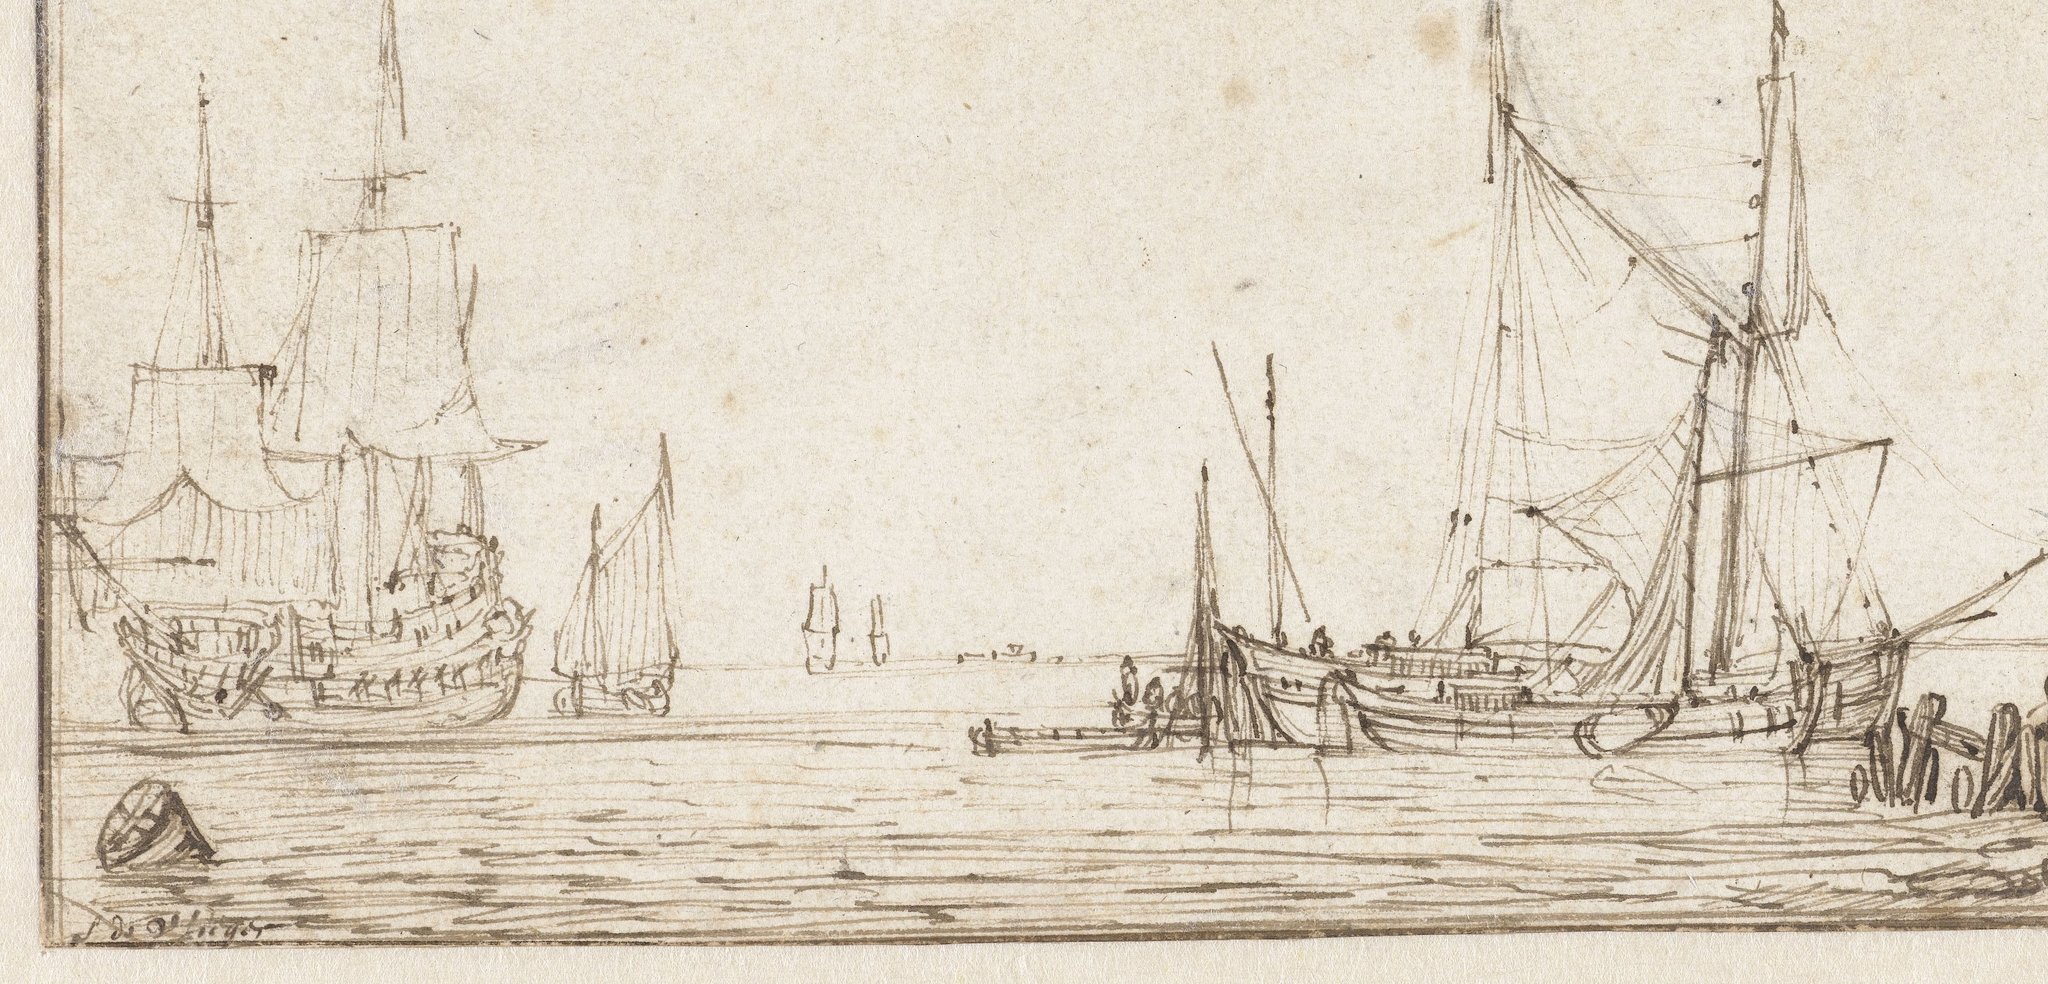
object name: drawing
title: Stille zee met schepen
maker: simon de vlieger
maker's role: draughtsman, painter, print maker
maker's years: 1600-1653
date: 1610-1653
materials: ink, paper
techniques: pen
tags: sailing-ship, sailing-boat, ship in the roads, roadstead